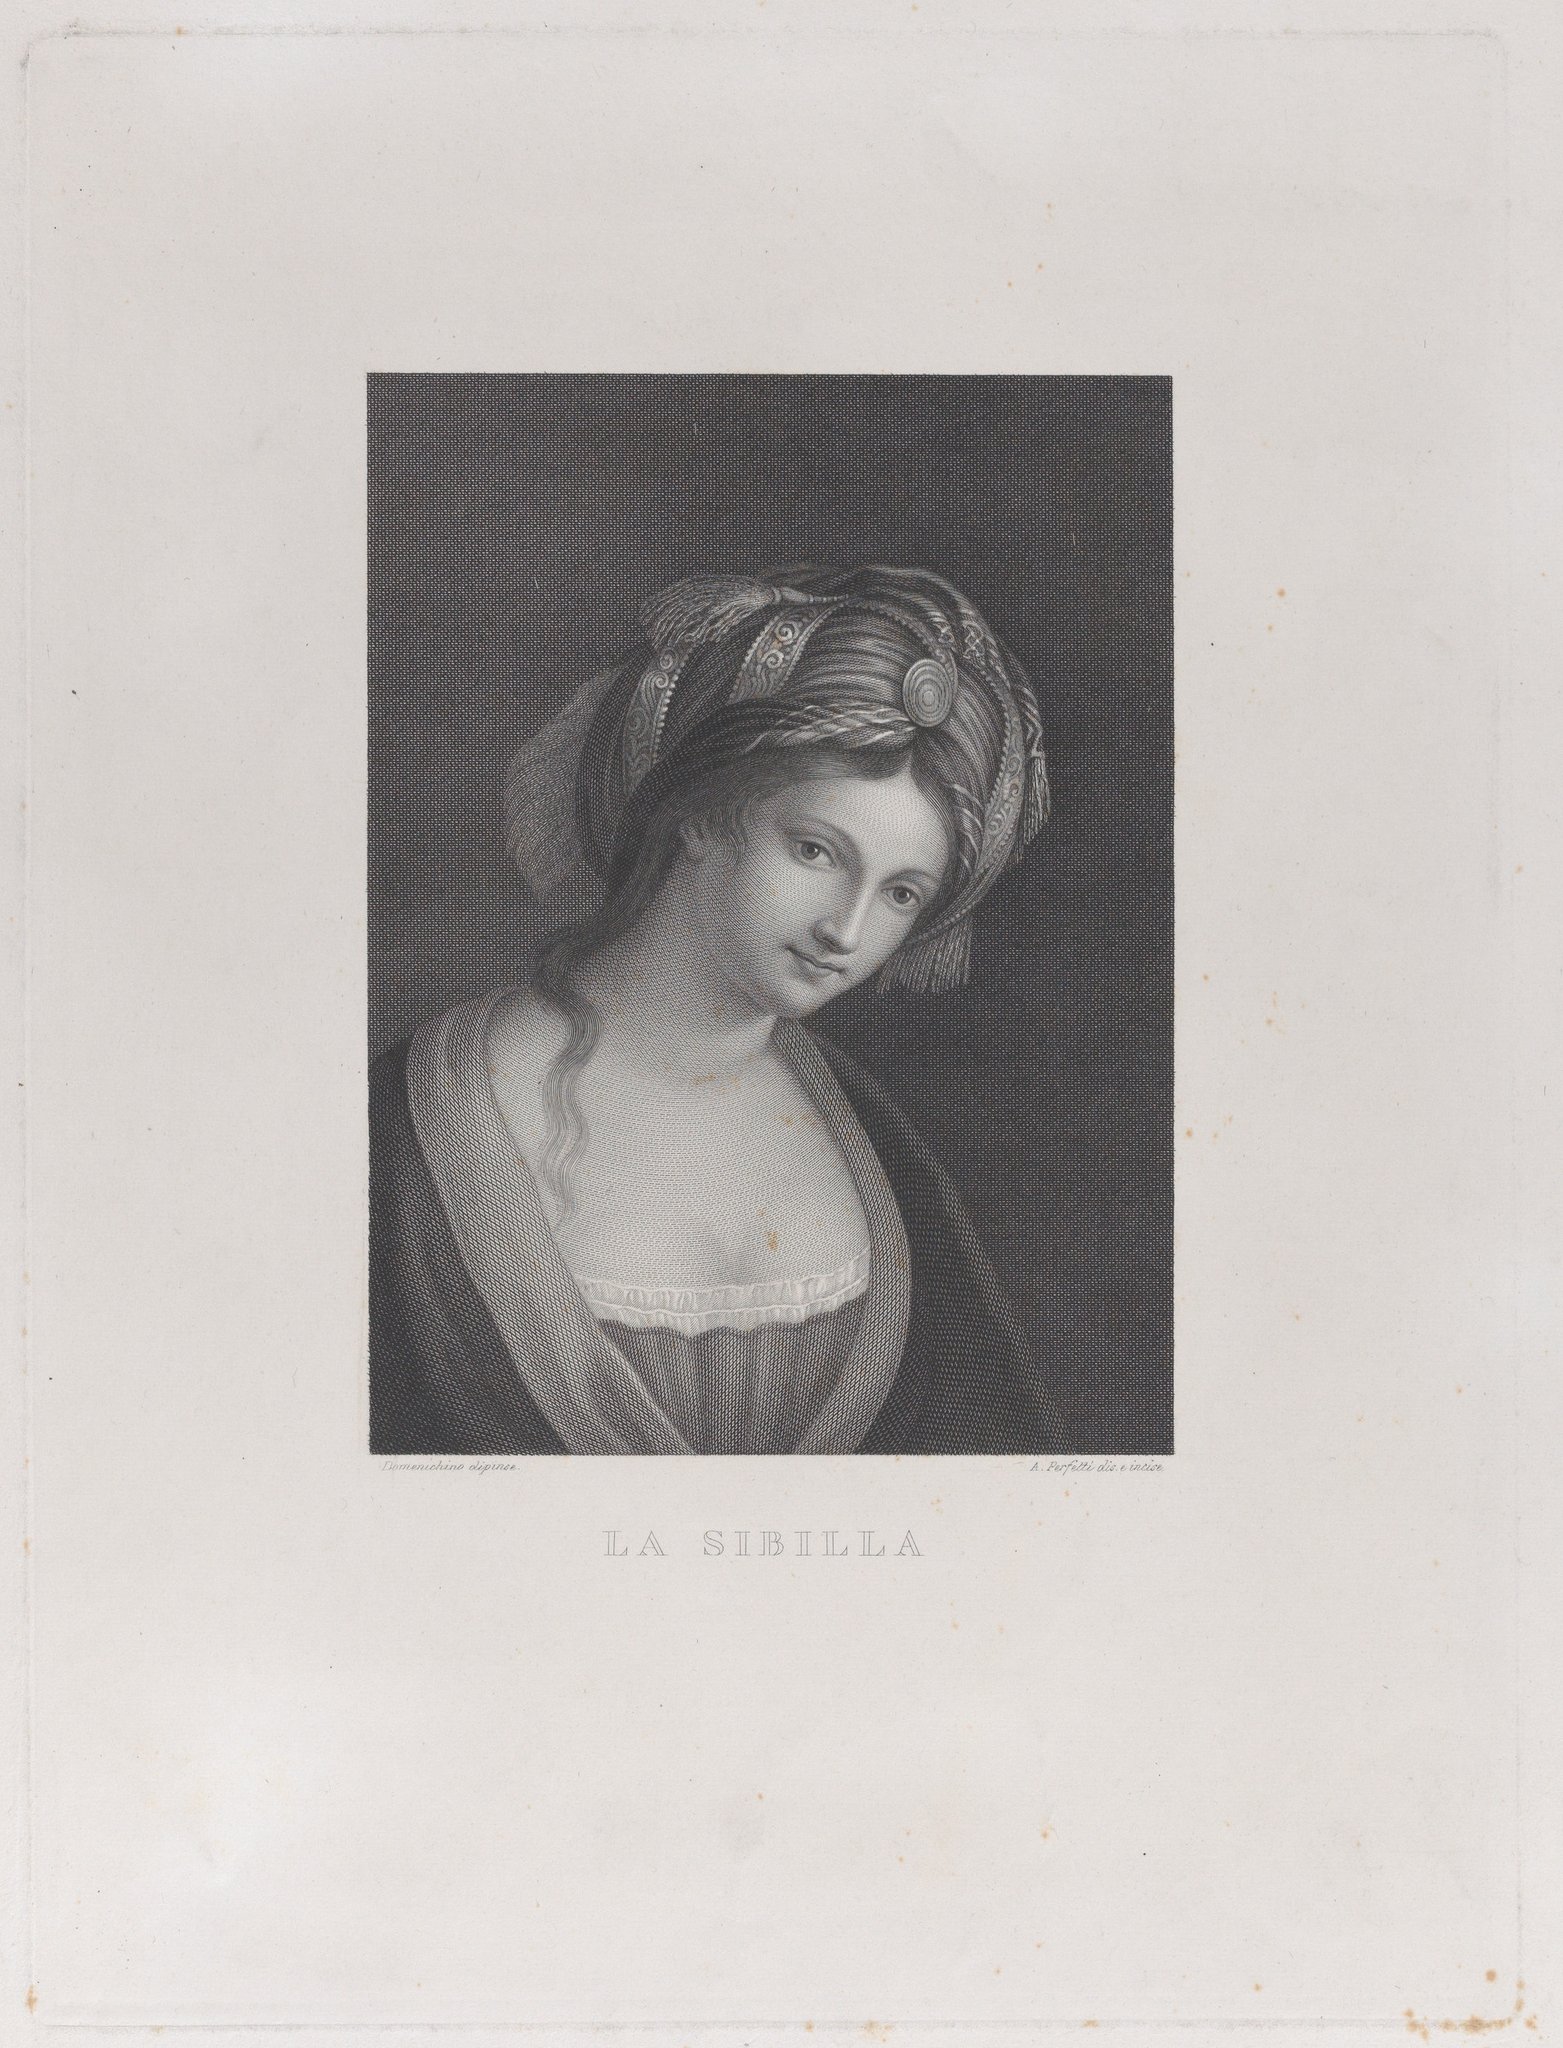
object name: print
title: A sibyl, head and shoulders, wearing a turban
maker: antonio perfetti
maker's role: artist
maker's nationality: italian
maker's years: 1792-1872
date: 1815-1870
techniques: engraving